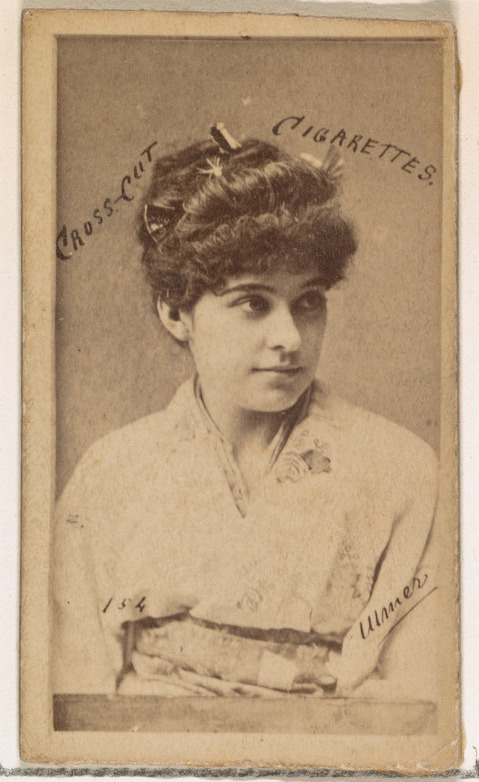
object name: print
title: Card Number 154, Geraldine Ulmer, from the Actors and Actresses series (N145-1) issued by Duke Sons & Co. to promote Cross Cut Cigarettes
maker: w. duke, sons & co.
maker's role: publisher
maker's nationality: american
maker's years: 1870-1920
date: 1880-1889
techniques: albumen silver print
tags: portraits,women,actresses